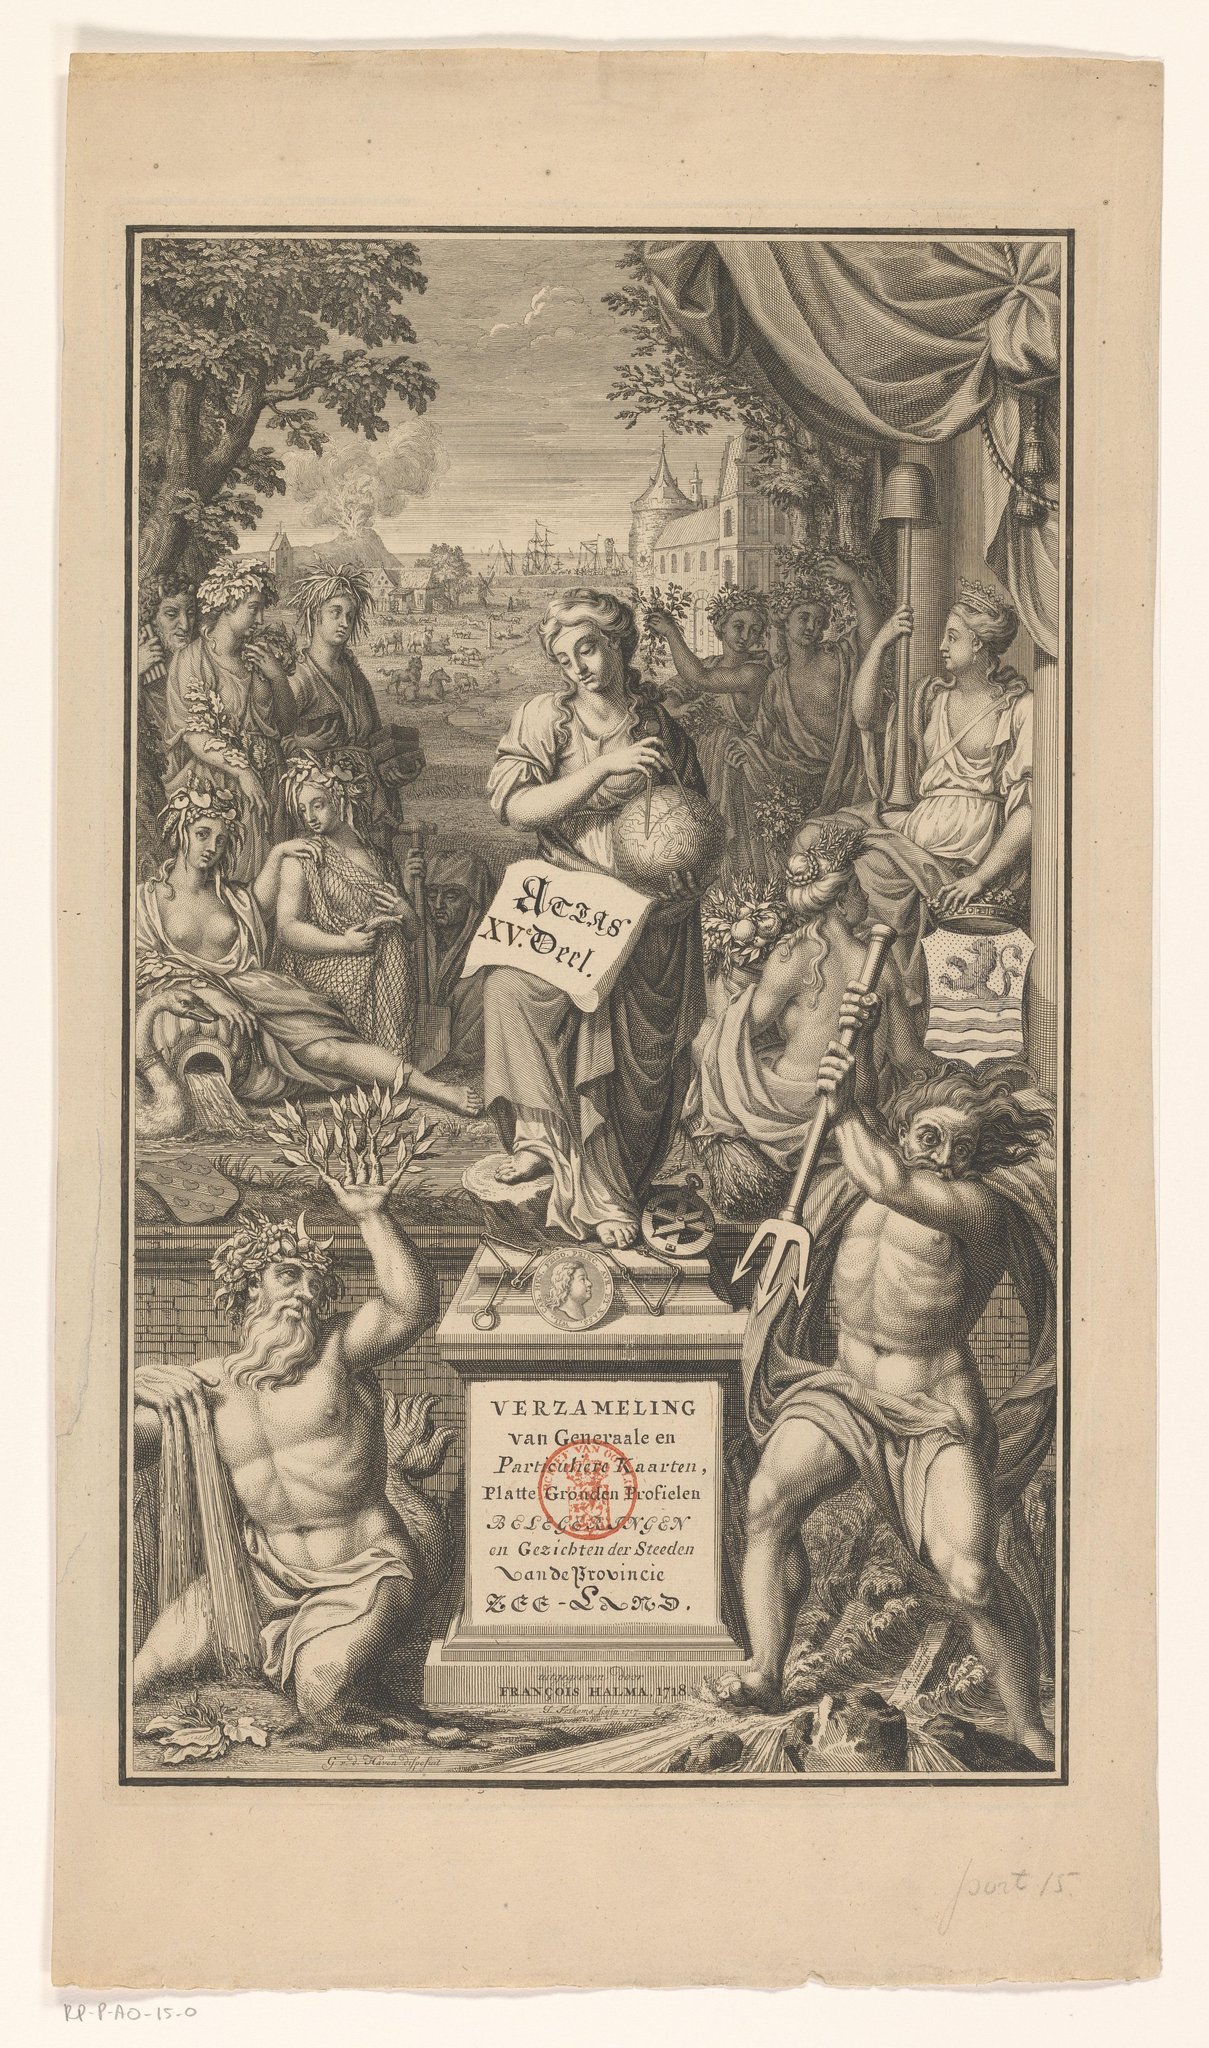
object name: titelprent, frontispice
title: Verzameling van Generaale en Particuliere Kaarten, Platte Gronden Profielen Belegeringen en Gezichten der Steeden van de Provincie Zee-Land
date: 1717-1718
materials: ink, paper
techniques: engraving, etching, pen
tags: commercial fishery, (story of) ceres (demeter), peat-cutting, 'astronomia', 'cosmografia'; 'cosmografia' (ripa), personifications of countries, nations, states, districts, etc., river-gods, 'corografia', 'geografia', 'hidrografia' (ripa), agriculture, fruitfulness, productiveness, fertility, fecundity; 'fecondità' (ripa), (story of) flora, coat of arms (as symbol of the state, etc.) (+ province; provincial), neptune as lord of the sea, zeeland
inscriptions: collector's mark: Lugt 19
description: Deze prent is hier gebruikt als titelprent van een deel van een ongebonden atlas; een verzameling cartografische en topografische prenten en tekeningen. Oorspronkelijk was de prent echter bedoeld als titelpagina voor een gebonden atlas met kaarten van Friesland, waardoor een deel van de hier volgende beschrijving betrekking heeft op die context. Op het voetstuk in het midden staat de personificatie van de cartografie, met in haar hand een aardbol die ze met een passer meet. Op haar bovenbeen rust een blad met het handgeschreven deel van de atlas (oorspronkelijk een kaart van Friesland). Aan haar voeten een meetketting, een rond (land)meetkundig instrument en een portret van Willem IV van Oranje-Nassau. Daaronder de handgeschreven titel van dit deel van de atlas. Ze houdt een wakend oog op Wispelturigheid (Wispeltuer), linksonder. Oorspronkelijk staat hij voor de wispelturigheid waar het Friese land zich naar moest schikken: een bos kon opeens onder water staan, want zijn lichaam smelt door het zoute water van de zee. Linksboven zijn hoofd een wapenschild met het wapen van Friesland (met schuinbalken en pompeblêden). De dreiging van de zee is rechtsonder verbeeld door een onstuimige Neptunus (Zeevoogd). Links en rechts van Cartografie nog meer figuren die oorspronkelijk betrekking hadden op Friesland en haar vruchtbare natuur, visserij en landbouw. Links, met haar arm leunend op een kruik waar water uitstroomt, een stroomgodin (Stroomvoogdess) met rechts van haar de personificatie van de visserij (Visschevang). Boven hen van links naar rechts: een sater met fluit als personificatie van de natuur (Natuer), de personificatie van de bossen met eikenloven (Woudman) en personificatie van de turfwinning (vrouw Veenbrand). Rechtsonder haar vrouw Onland, die rouwt om de schade die de turfwinning aan het land veroorzaakt. Rechts van Cartografie zit Flora en/of Ceres (vrouw Veldgewas) met korenaren en cornucopia, ze staat voor de overvloed die voortvloeit uit het land. Boven haar, op de achtergrond, twee vrouwelijke personificaties die in verband staan met groene weides en/of grasvelden: Beemdeheil en Graazevol. Rechts, met in haar ene hand een bazuin met daarop een vrijheidshoed en in de andere hand een schild met het wapen van Zeeland, de personificatie van het gebied van dit deel van de atlas (oorspronkelijk de Friese Maagd met het provinciewapen met twee leeuwen). Op de achtergrond een landschap met kenmerkende Friese elementen, zoals het Sjaerdemaslot te Franeker en de vuurspuwende Rode Klif te Gaasterland (zou in de oudheid een vulkaan zijn geweest).